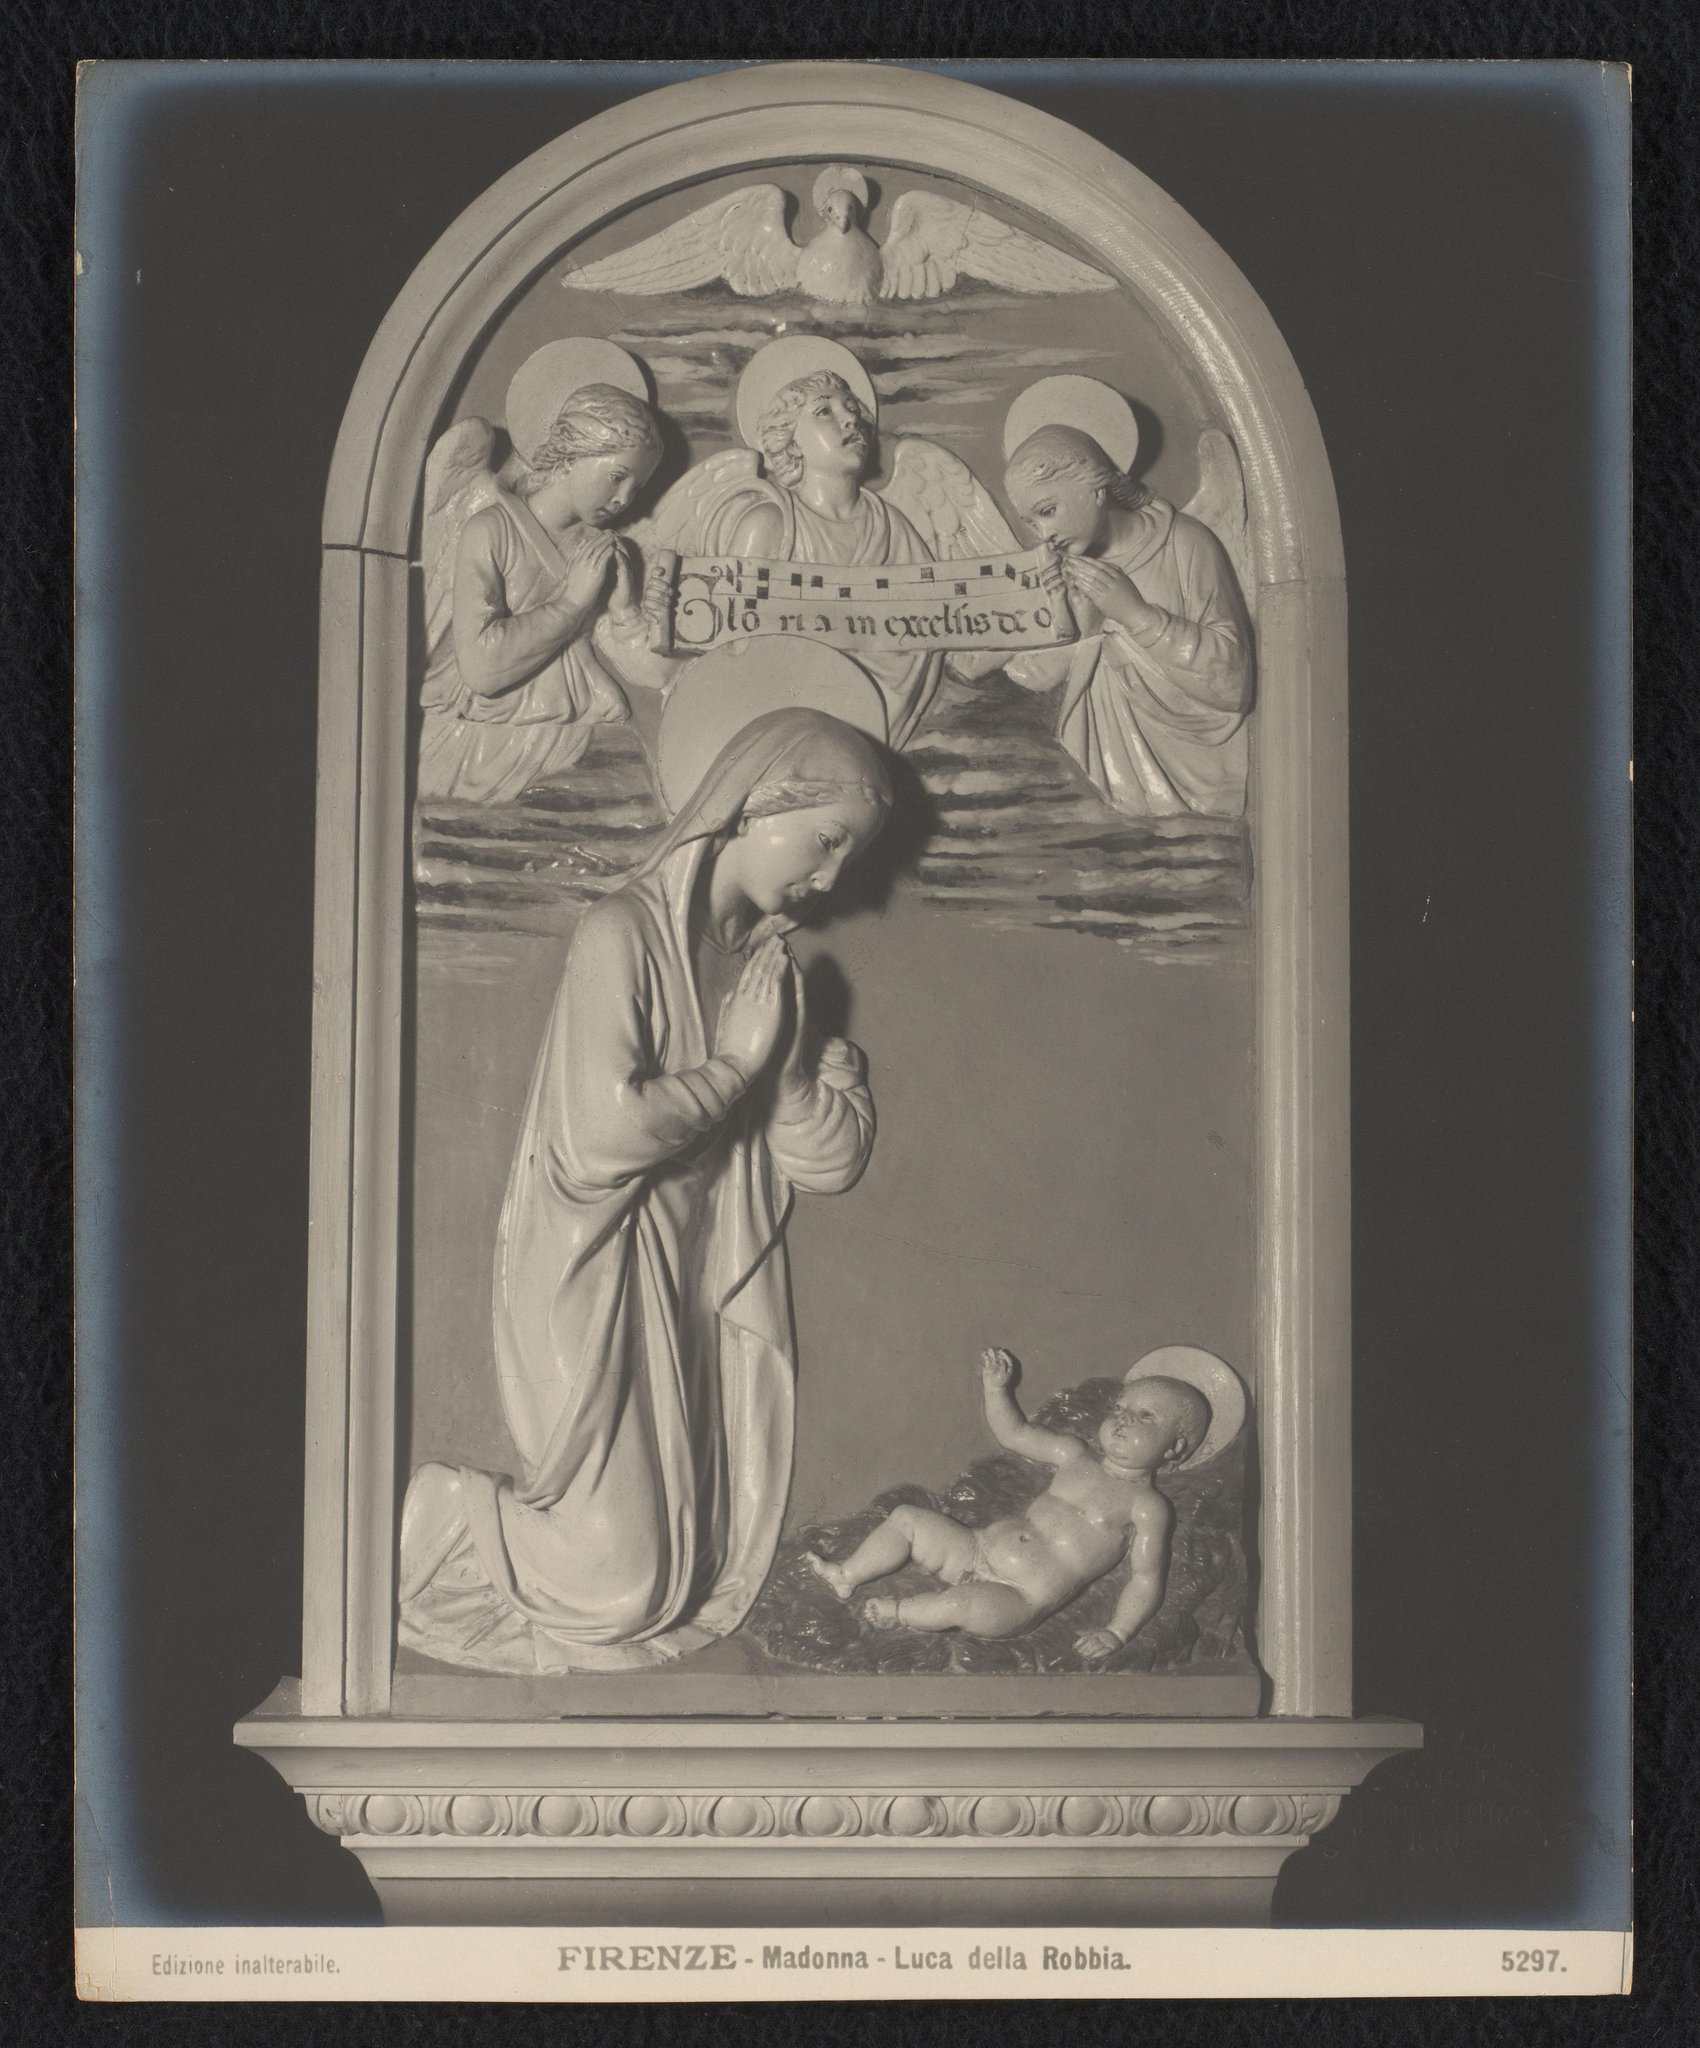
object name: photograph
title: Museo Nazionale - Madonna in Adorazione - Robbia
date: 1901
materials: paper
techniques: gelatin silver print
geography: berlin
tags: madonna: i.e. mary with the christ-child, interior ~ representation of a building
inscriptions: collector's mark: ‘RIJKS SCHOOL VOOR KUNSTNIJVERHEID/ GROEP’, number: ‘5297.’, inscription: ‘Edizione inalterabile.’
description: Deze foto maakt deel uit van een omslag.